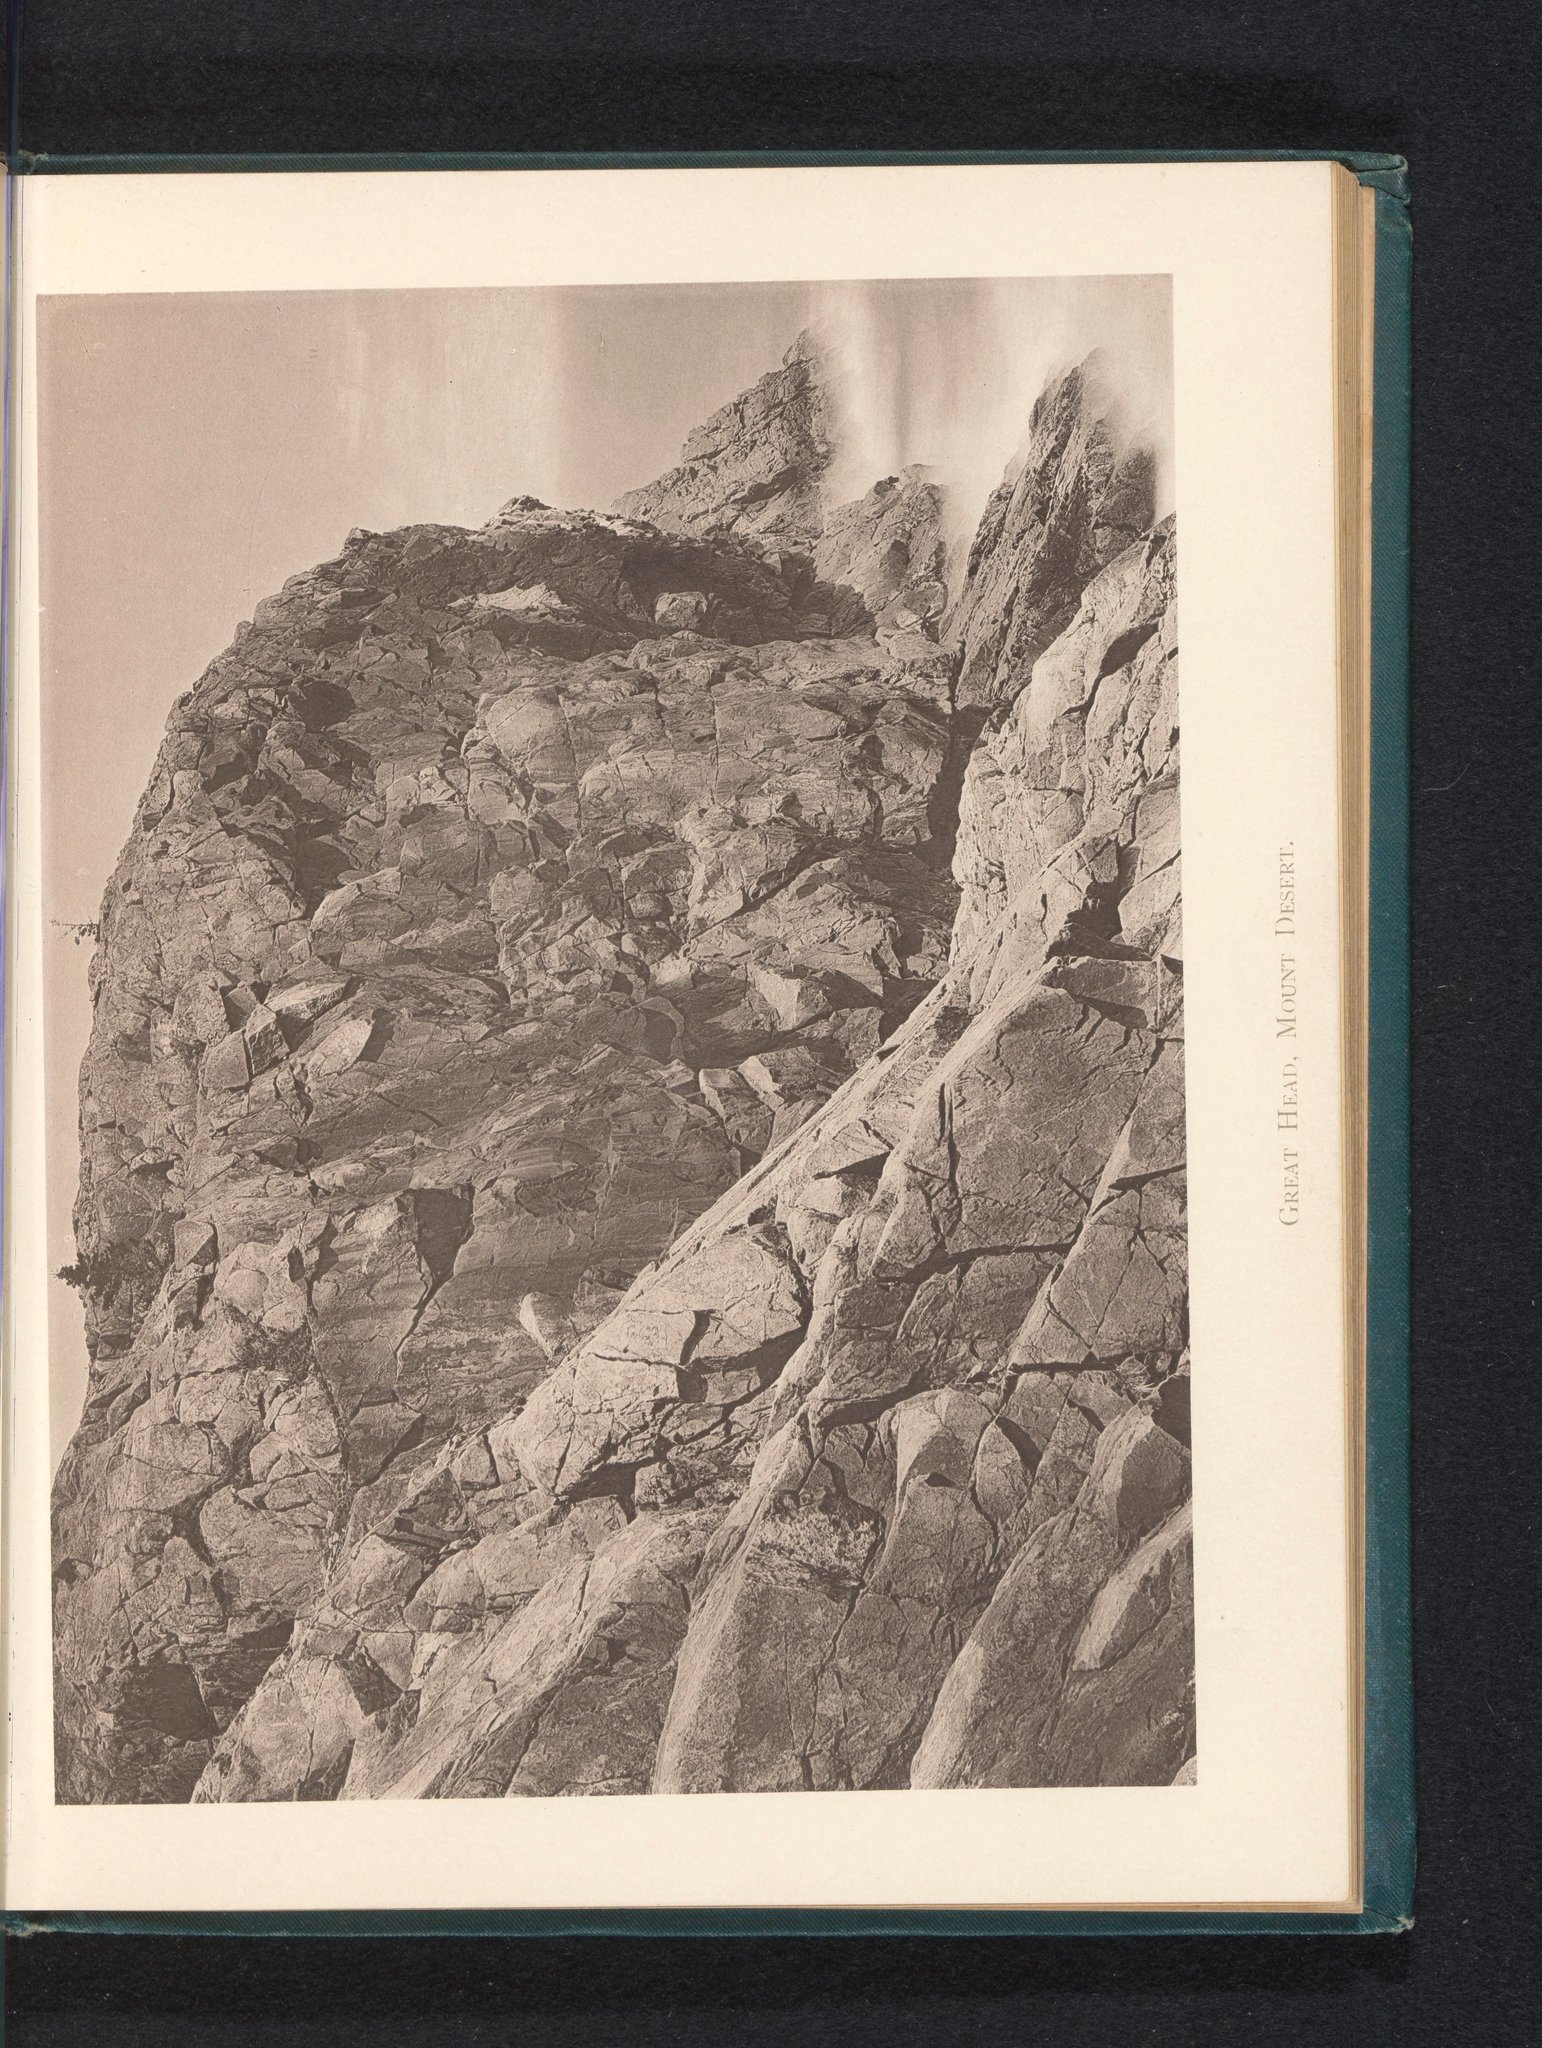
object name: photomechanical print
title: Gezicht op Great Head op Mount Desert Island, Maine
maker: Anonymous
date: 1875-1880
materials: paper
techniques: photograph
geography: great head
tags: cape (coast)